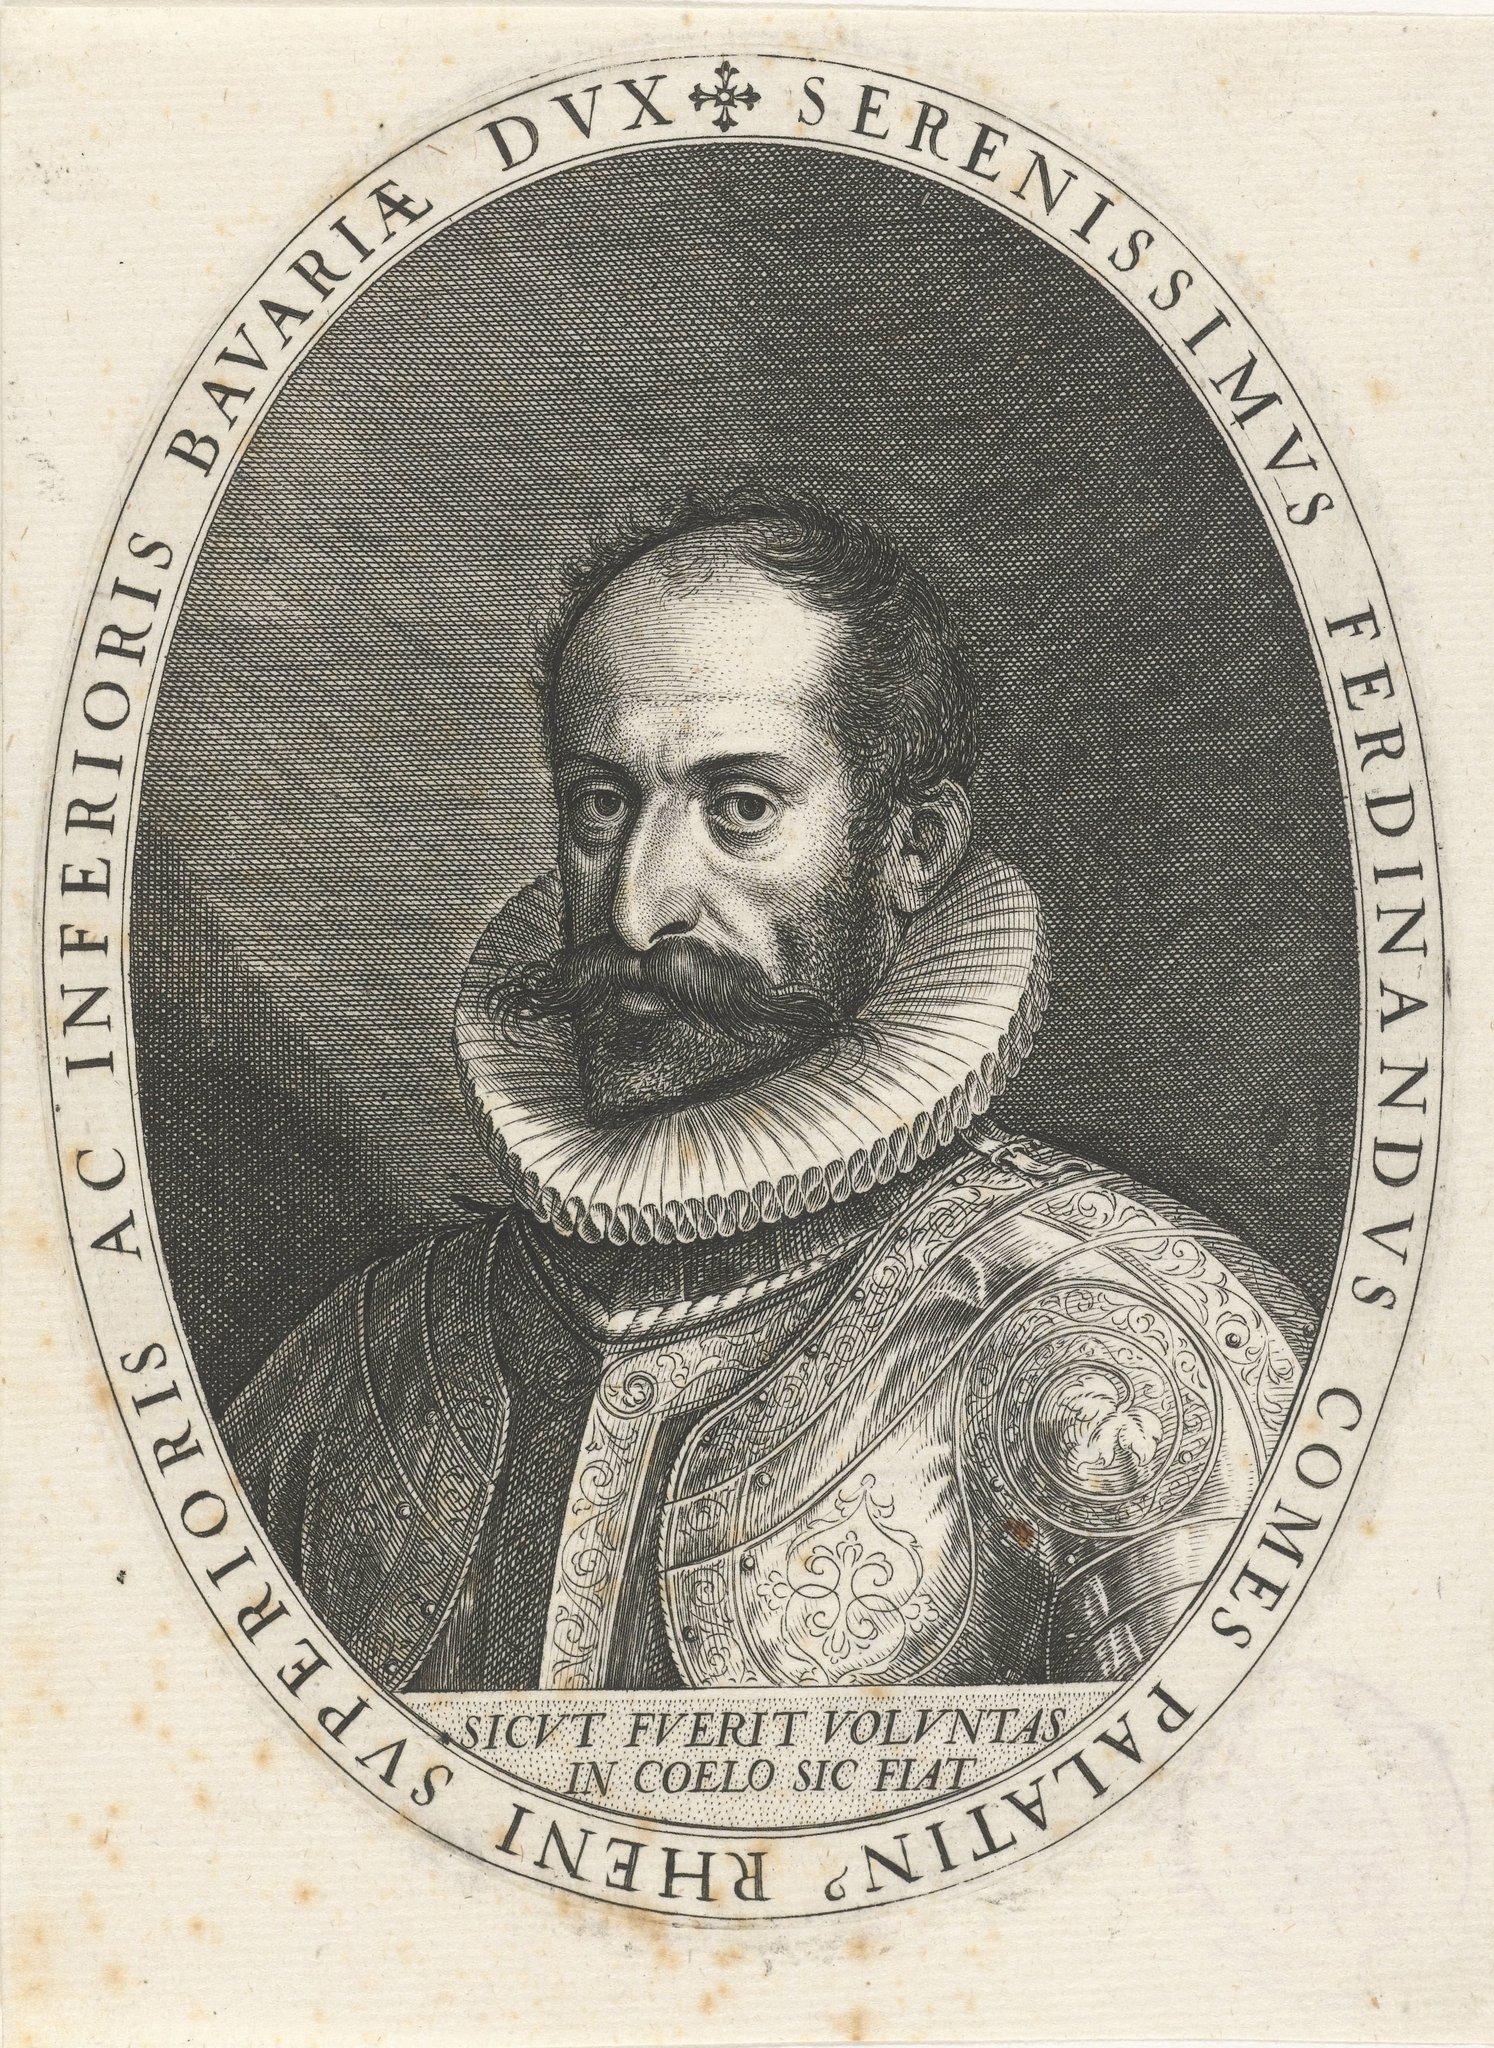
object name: print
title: Portret van Ferdinand van Beieren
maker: johann sadeler (i)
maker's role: print maker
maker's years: 1550-1600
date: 1560-1600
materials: paper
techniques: engraving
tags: neck-gear ~ clothing (with name), moustache, armour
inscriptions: collector's mark: Lugt 240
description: Ferdinand van Beieren, in harnas waarboven brede plooikraag. Breed uitstaande snor en puntbaardje. Buste naar links, in ovaal met randschrift. Aan de voet van het portret 2 regels onderschrift in Latijn: 'Sicut fuerit voluntas / in coelo sic fiat'.